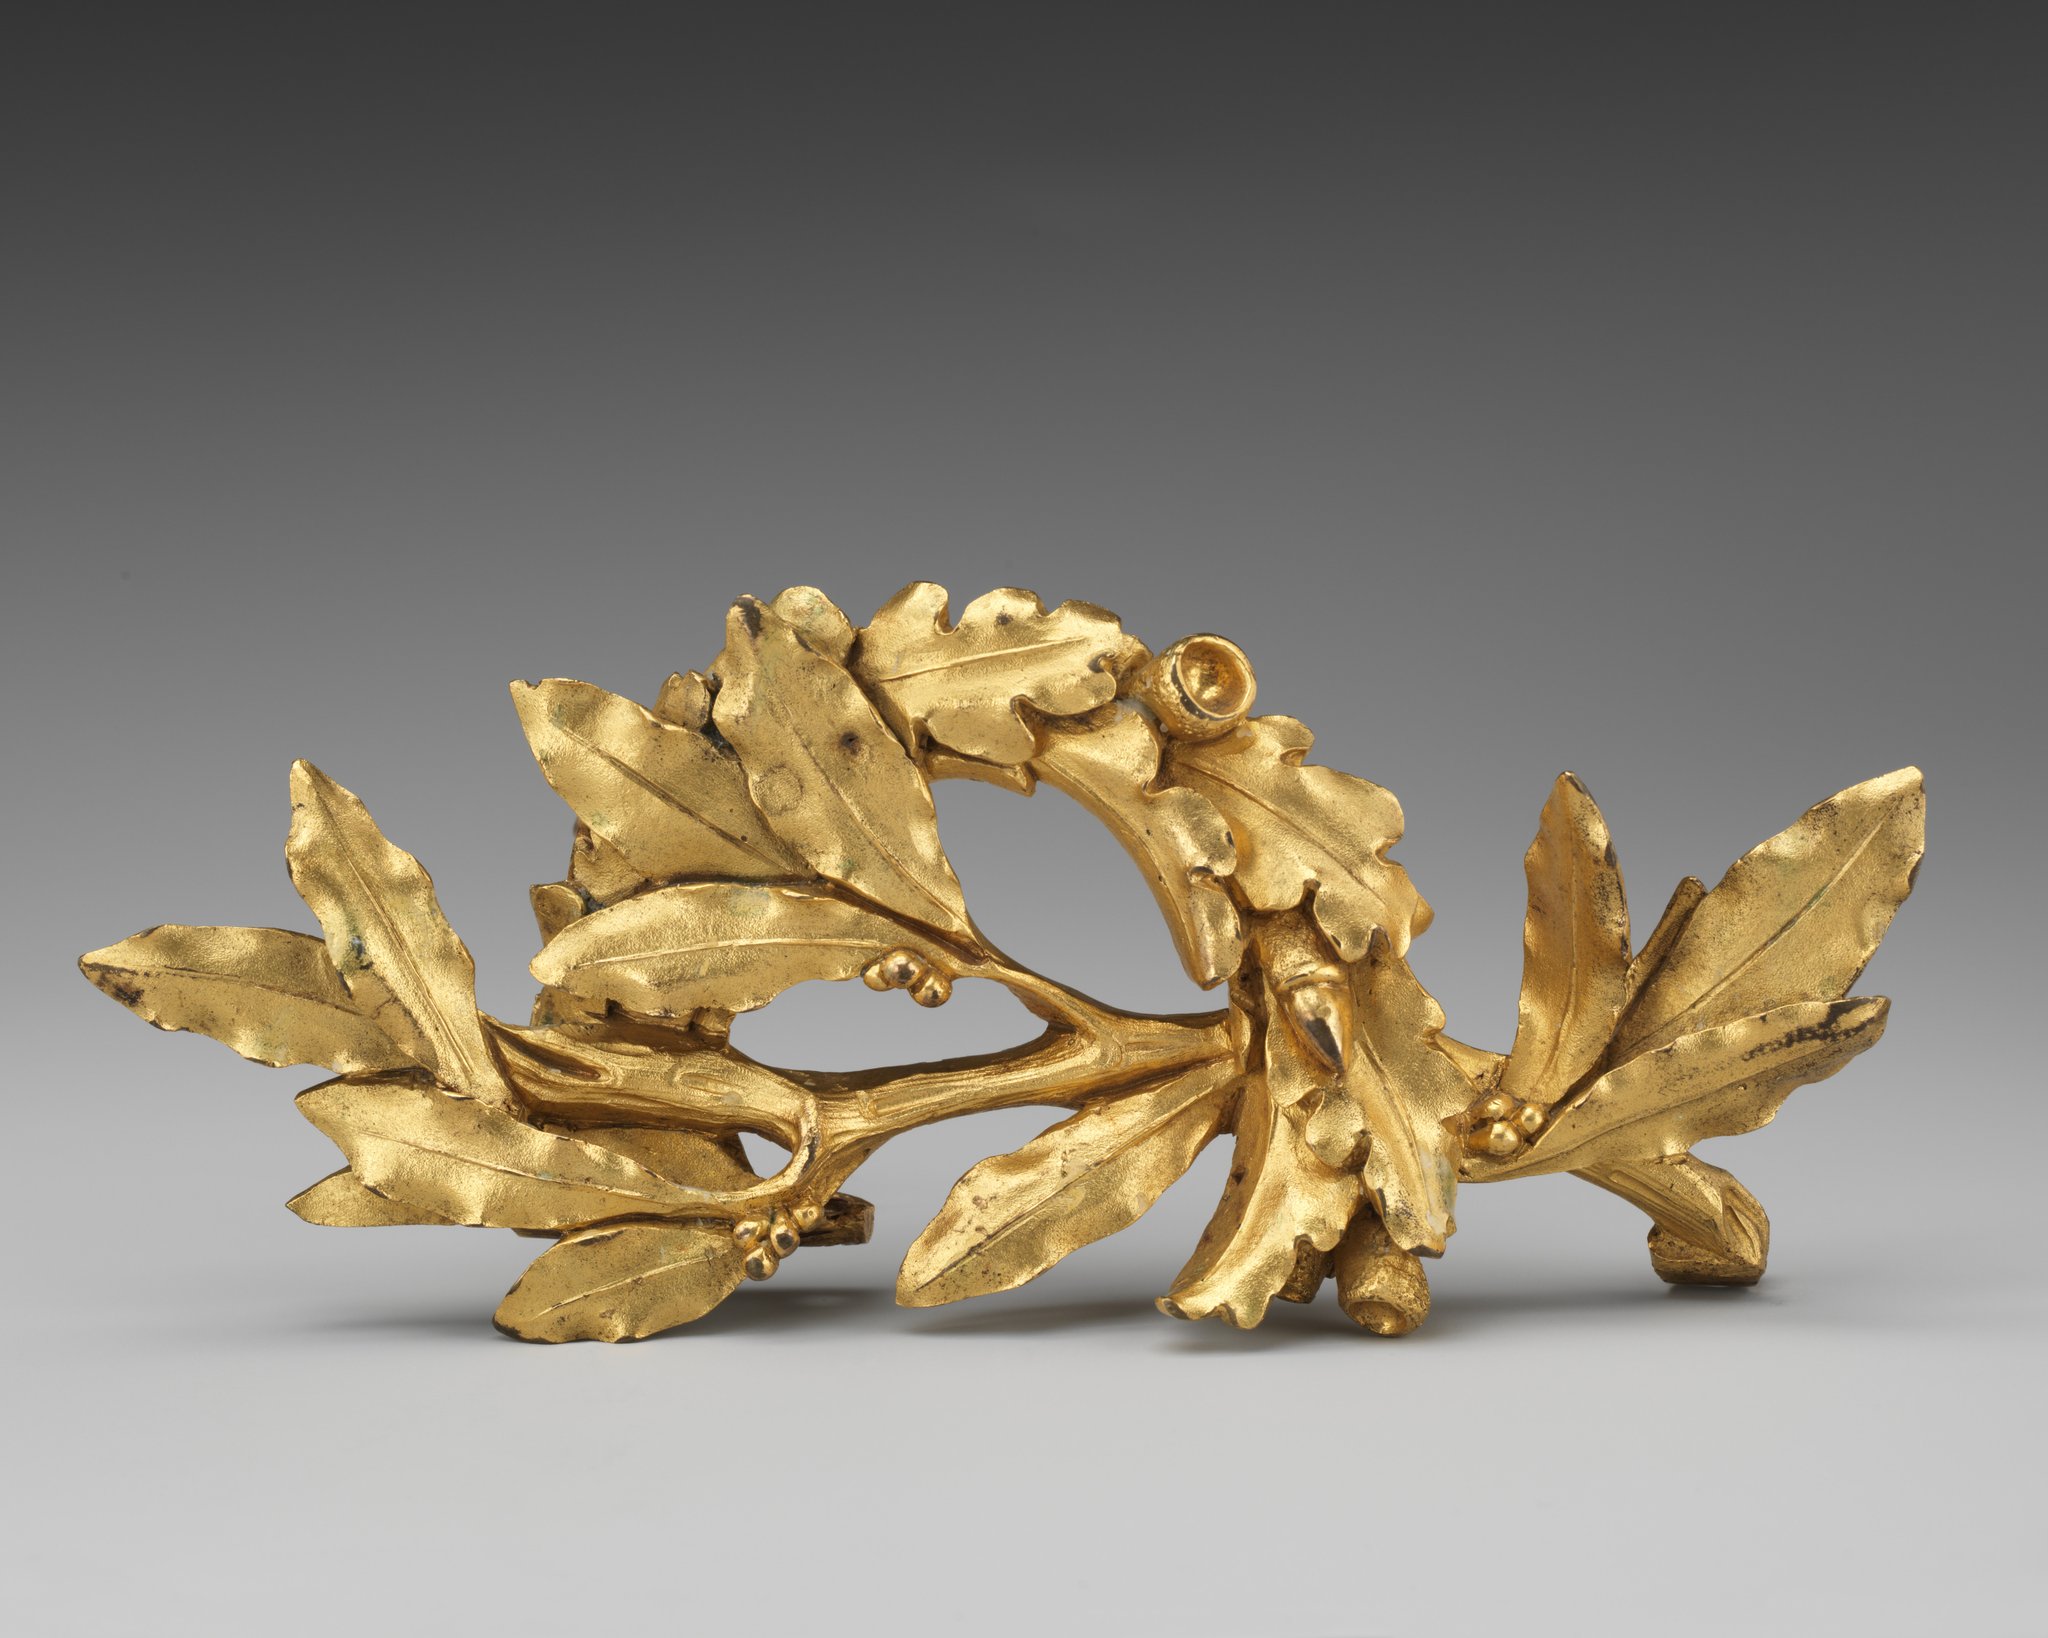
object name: ornament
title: Wreath consisting of laurel and oak branches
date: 1760-1770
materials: gilt bronze